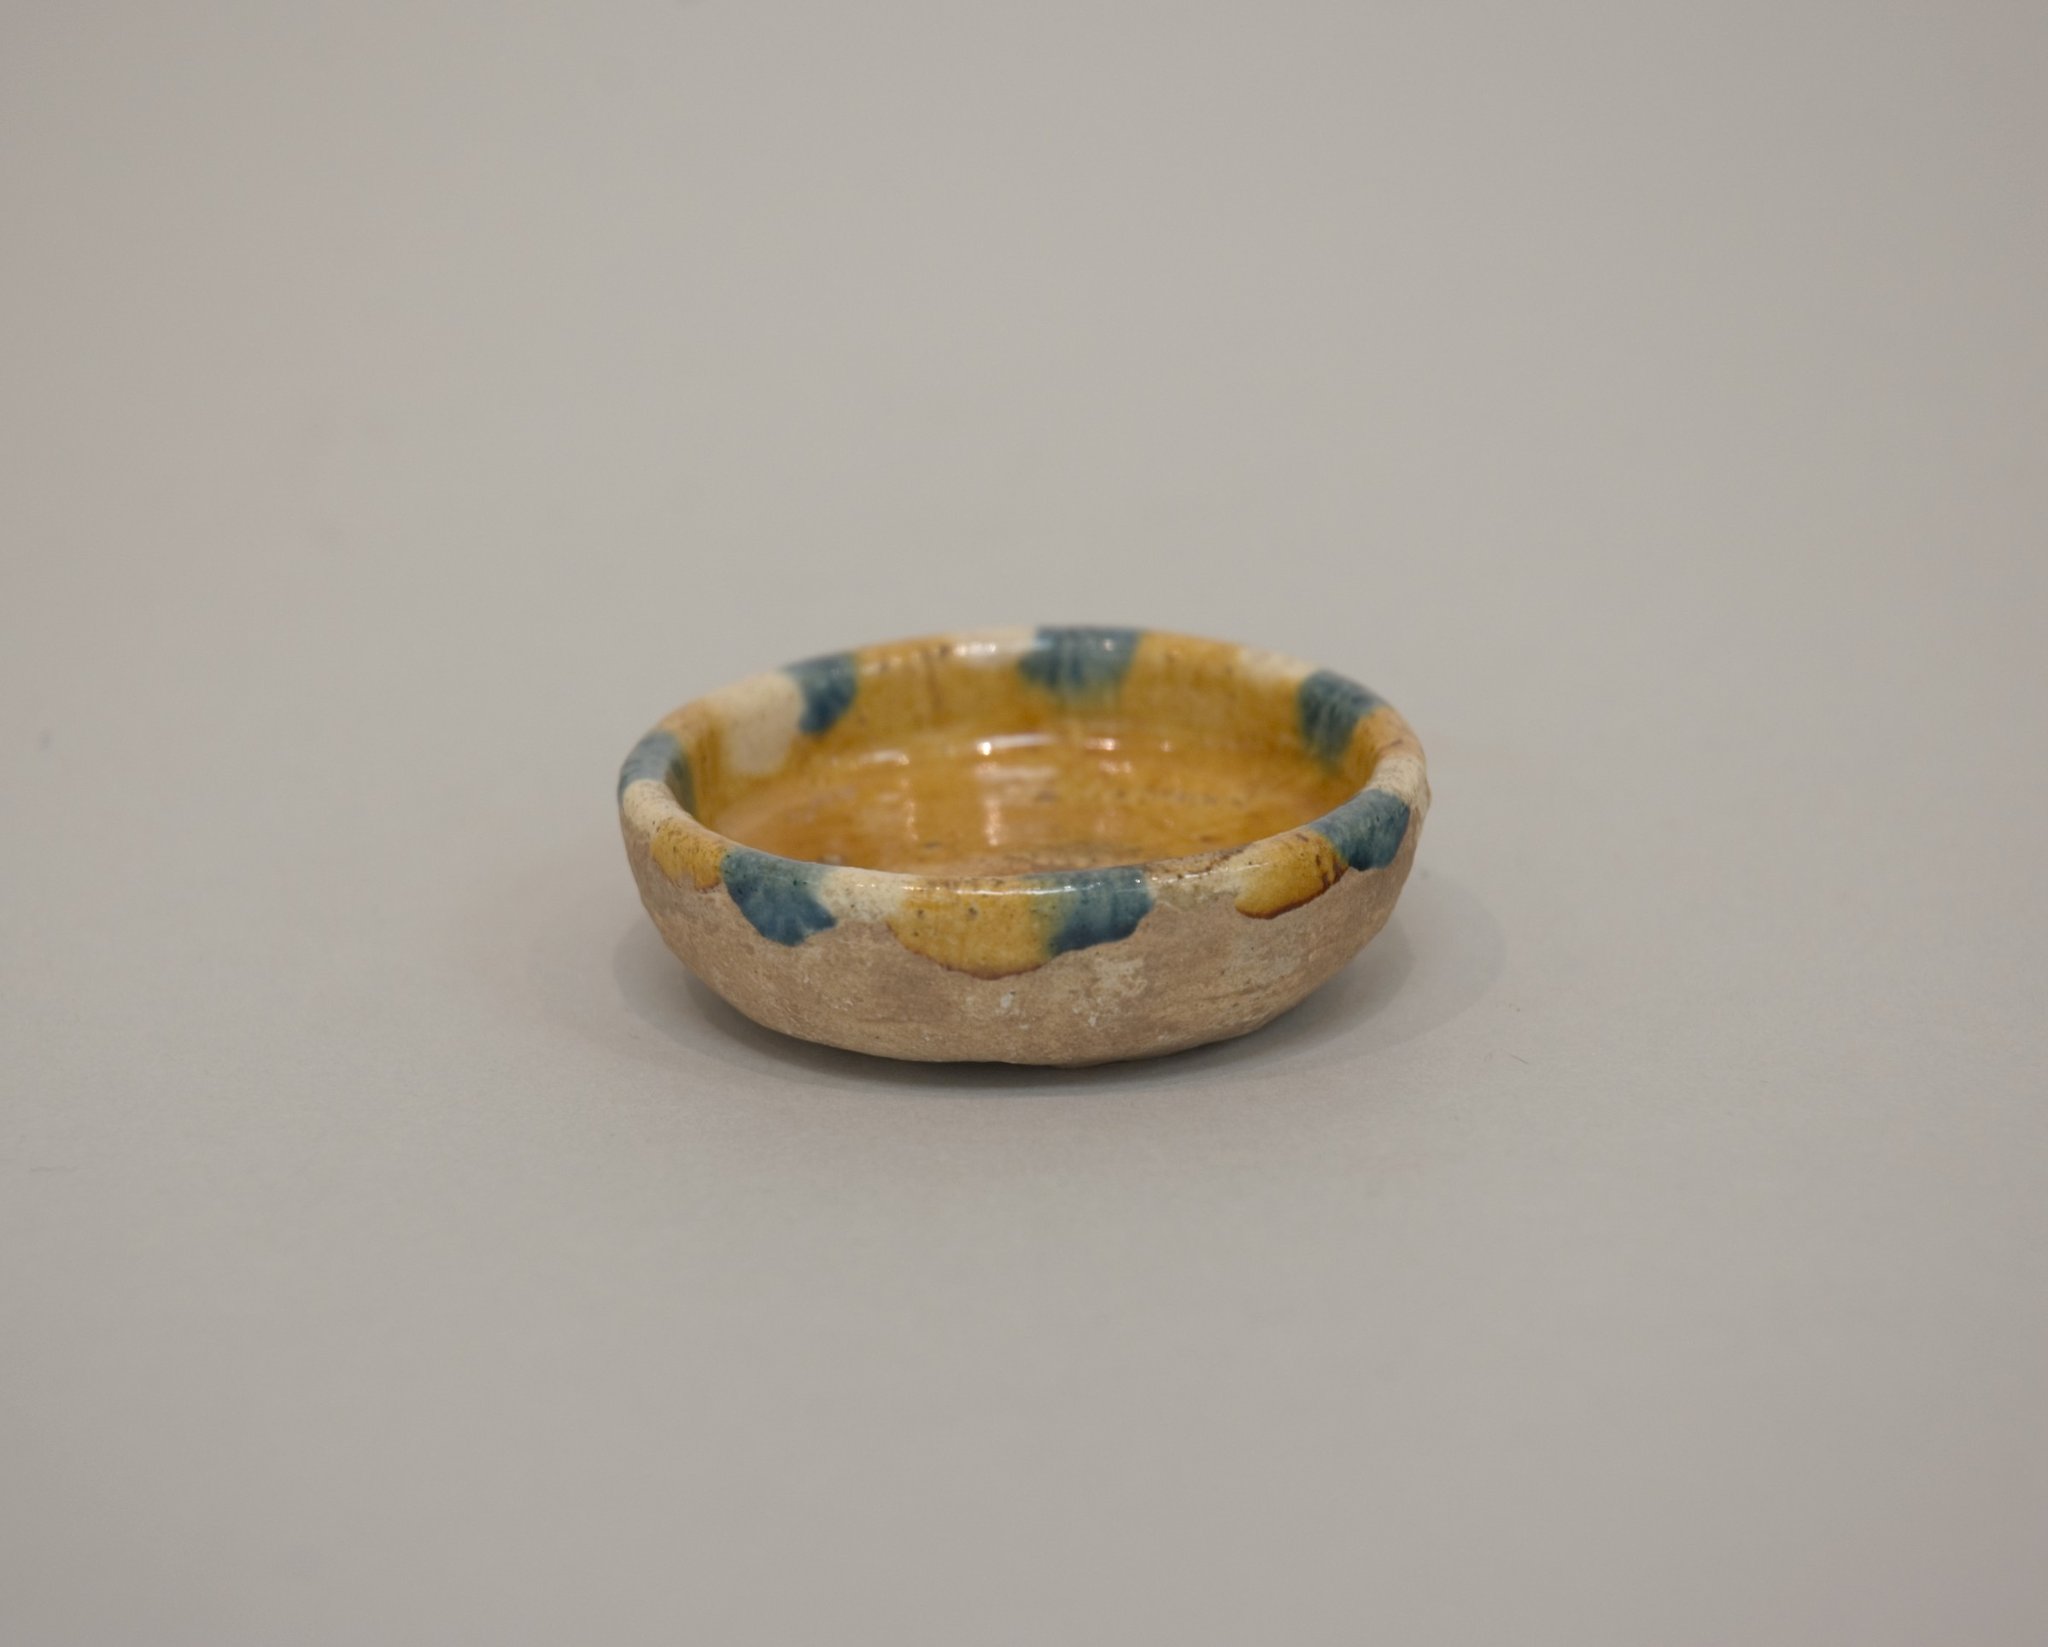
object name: dish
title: Minature dish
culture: chinese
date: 701-800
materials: earthenware, glaze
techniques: polychrome